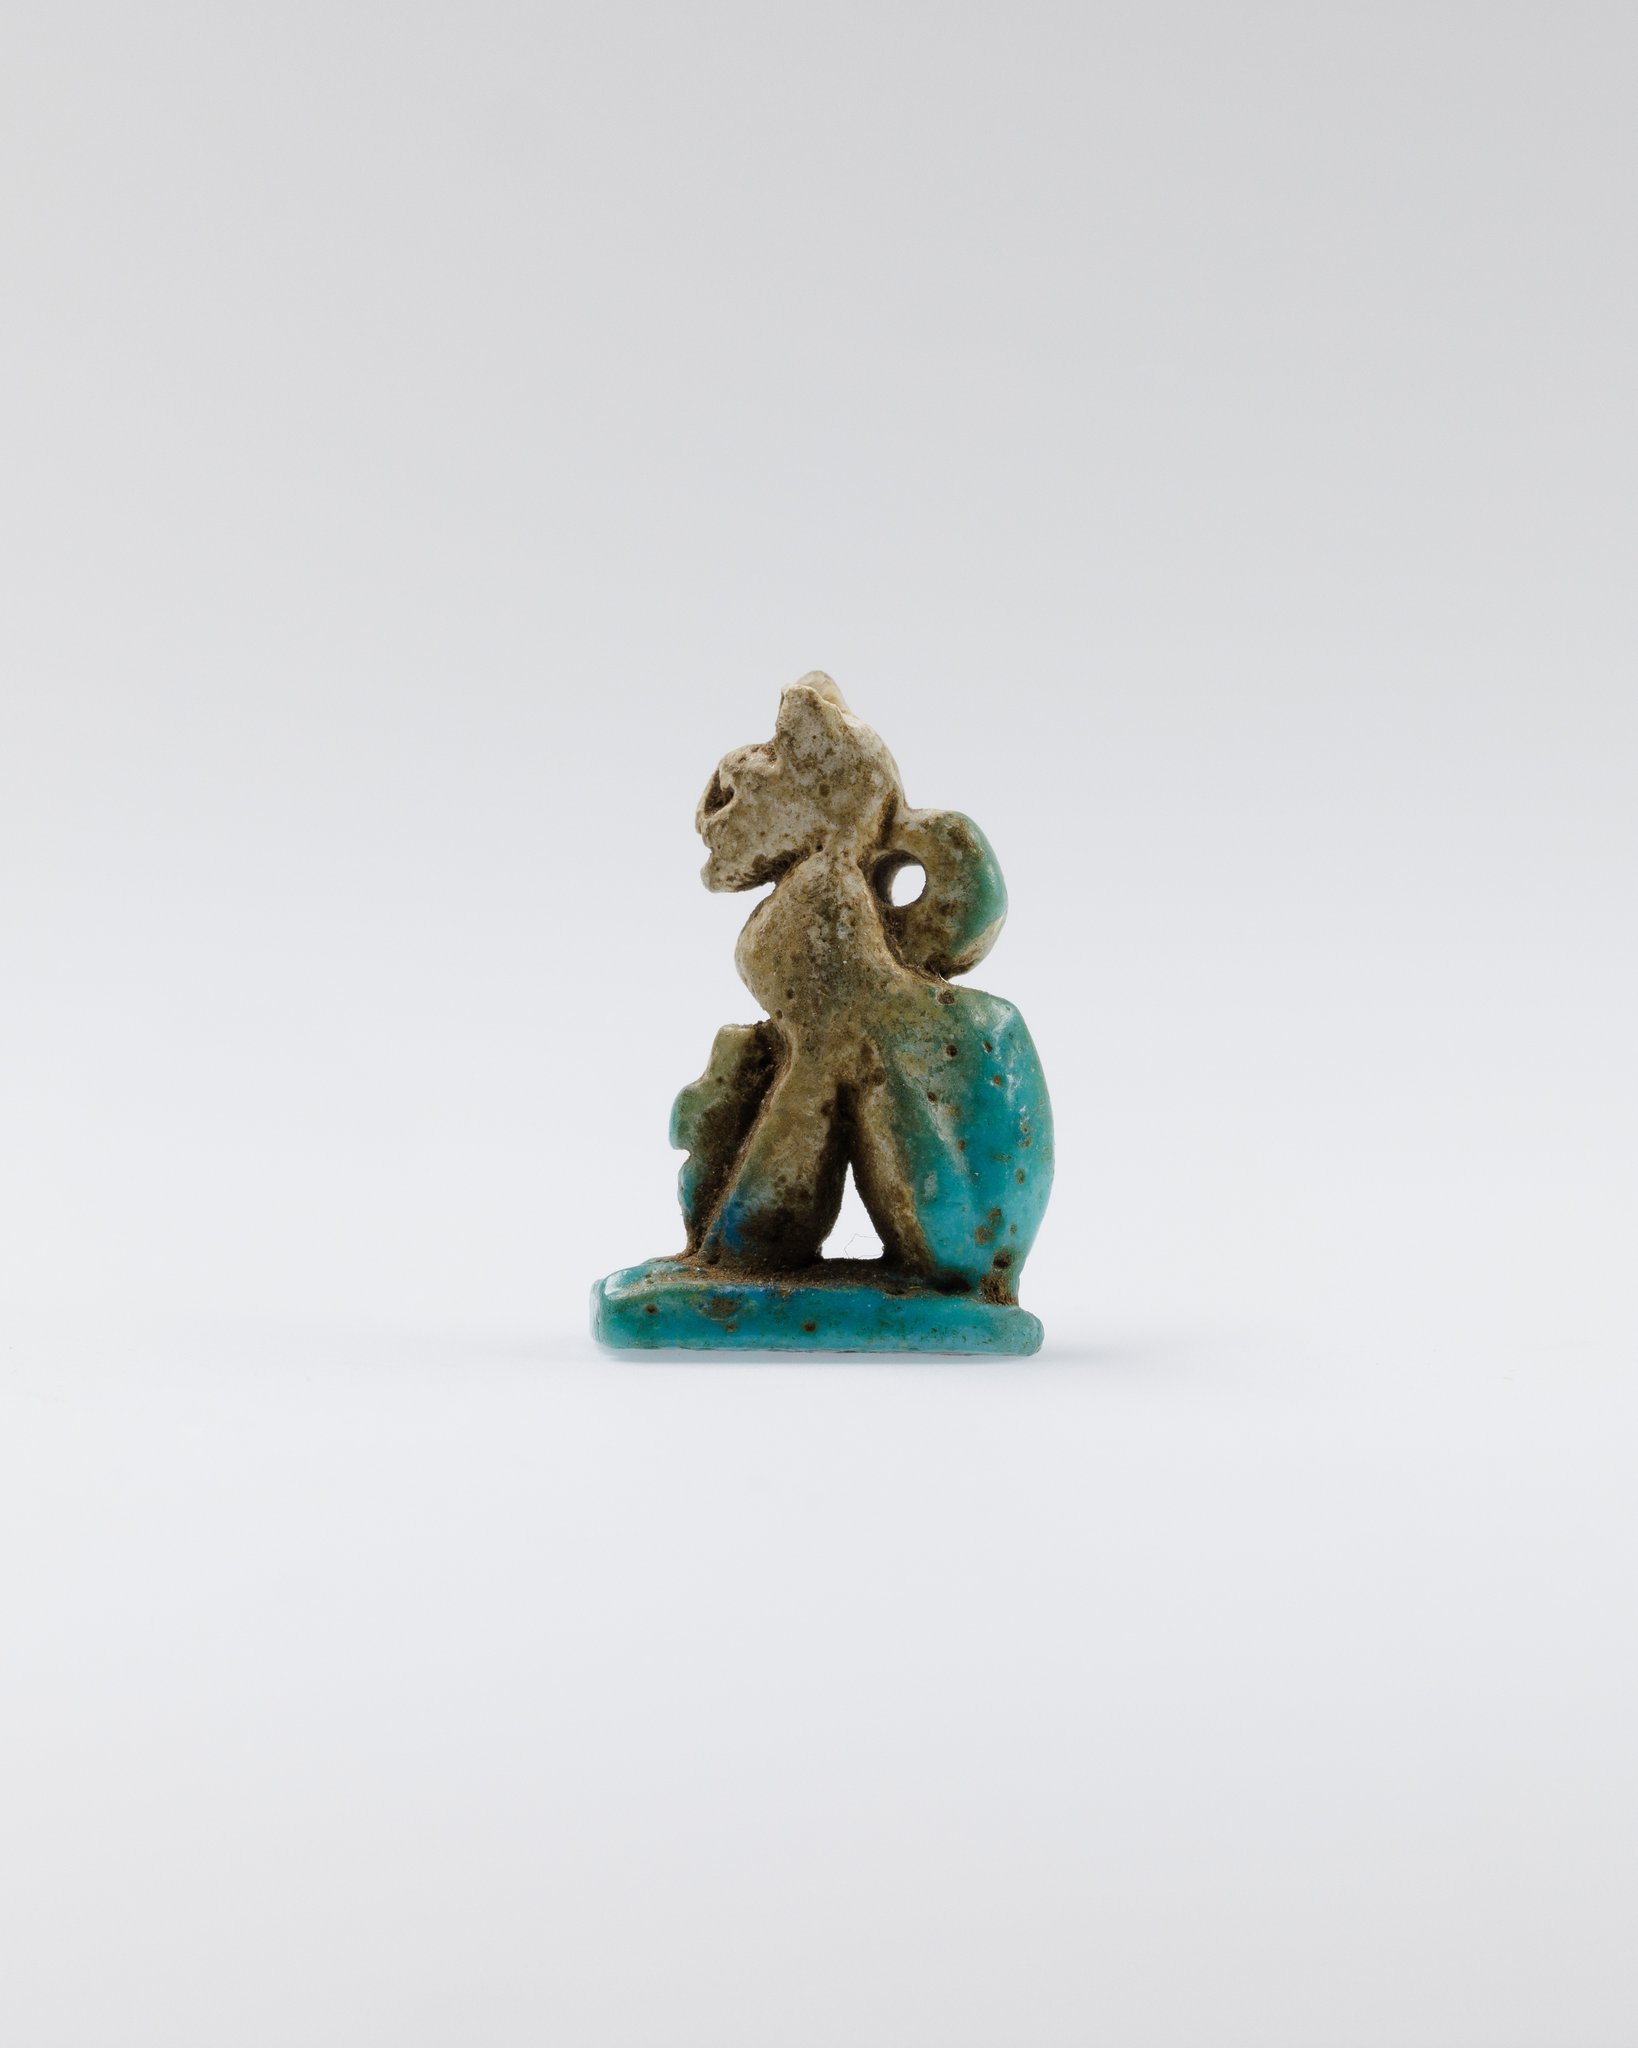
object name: amulet, cat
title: Cat amulet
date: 664-630 BCE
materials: faience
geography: egypt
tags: cats